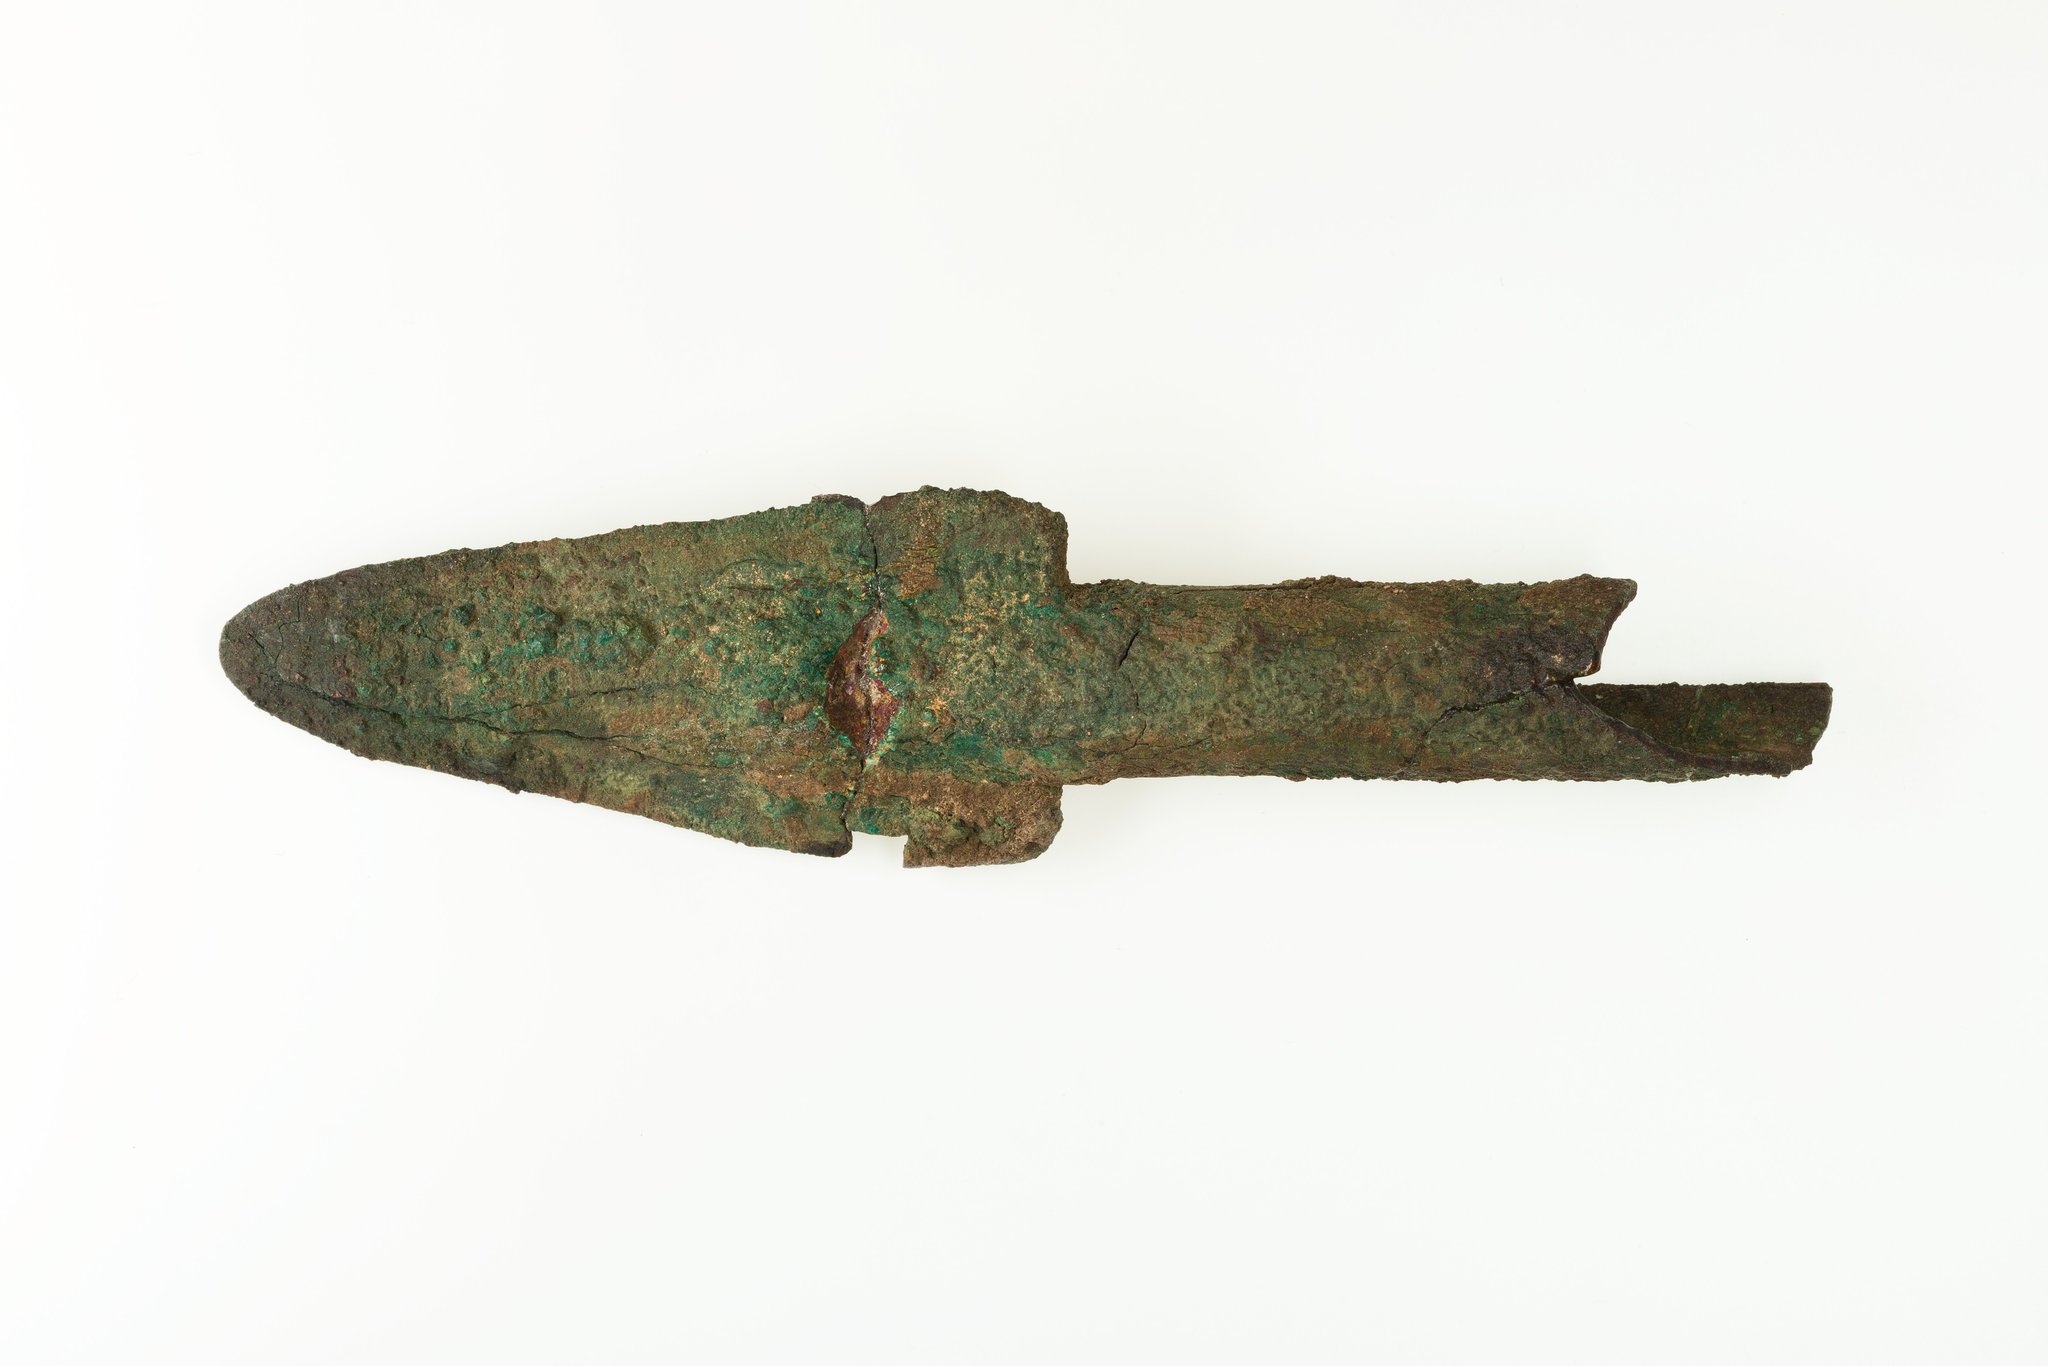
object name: spearpoint, socketed javelin head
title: Spearhead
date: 1850-1640 BCE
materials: bronze, copper alloy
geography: egypt